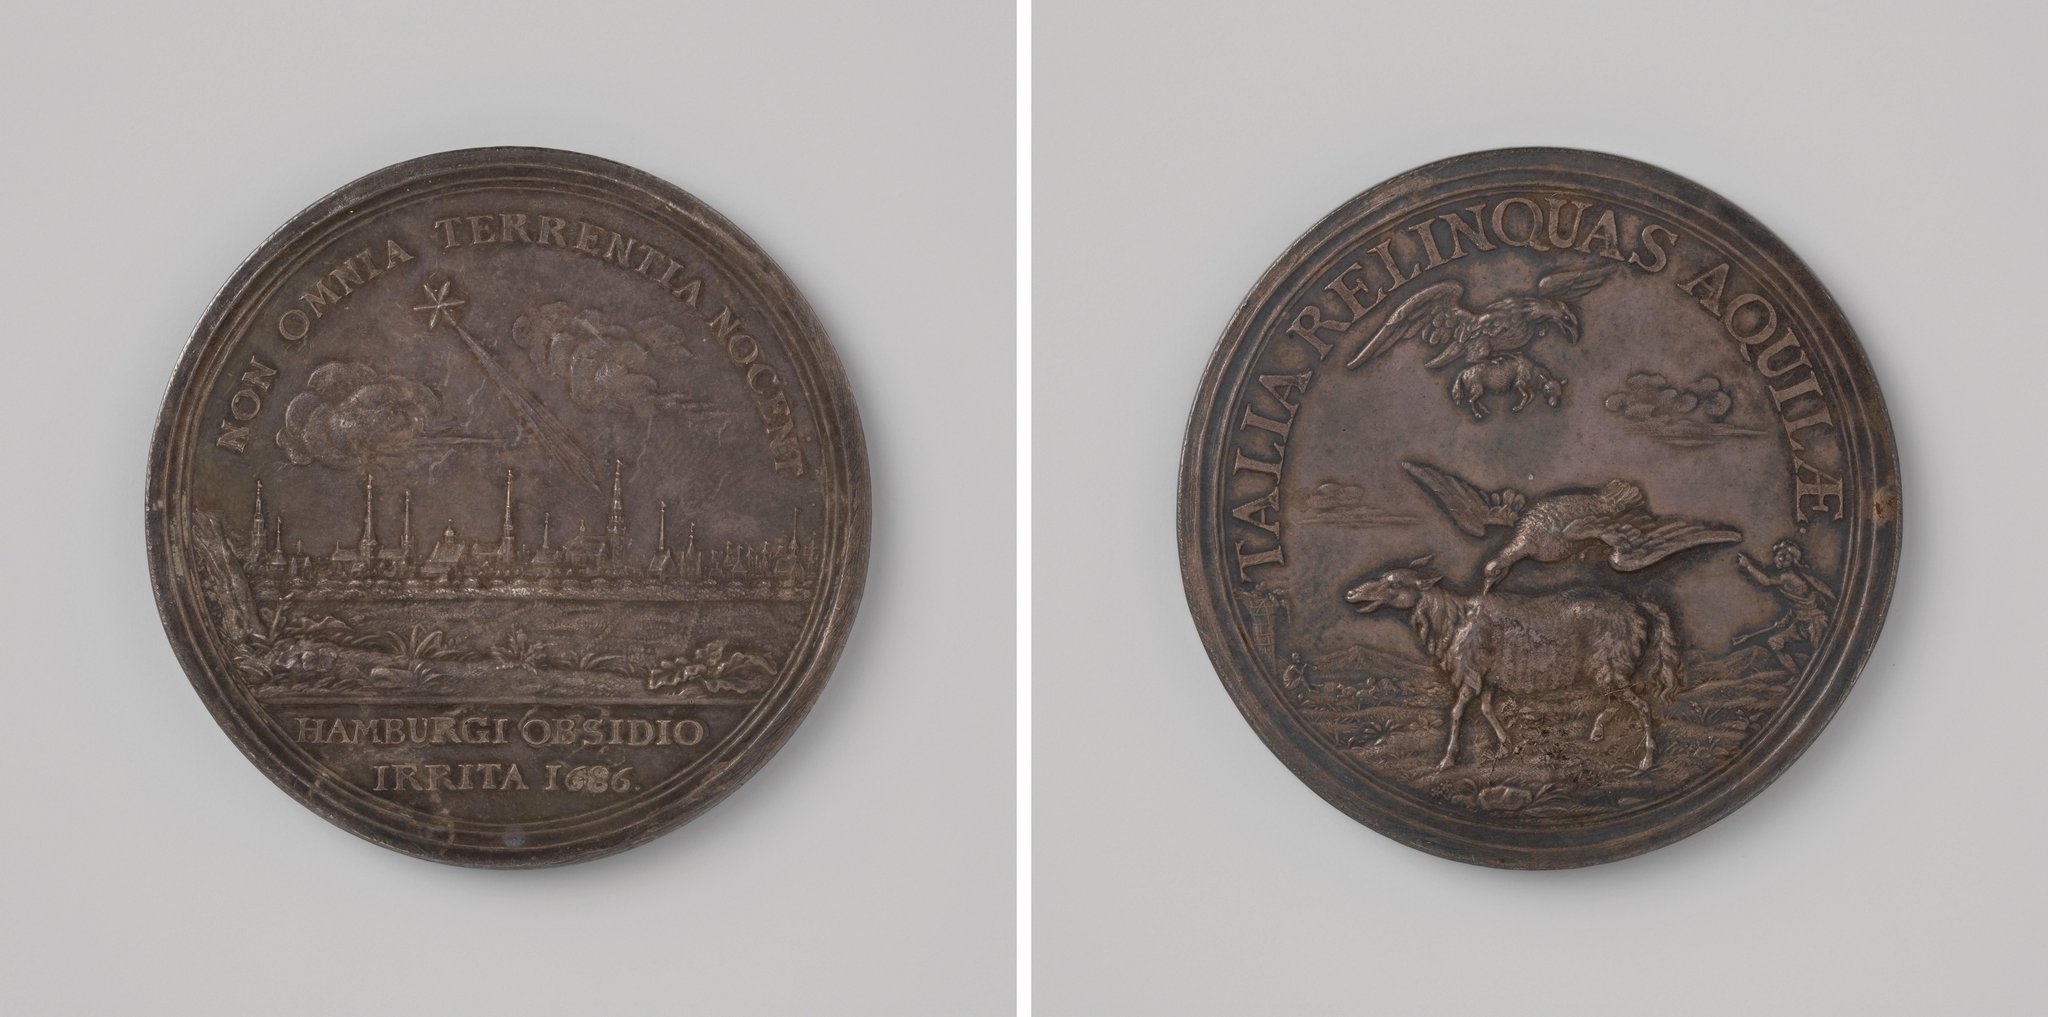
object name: history medal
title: Mislukte belegering van Hamburg door de koning van Denemarken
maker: Anonymous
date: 1686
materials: silver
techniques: striking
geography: germany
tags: copenhagen (city)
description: Zilveren penning. Voorzijde: gezicht op stad Hamburg met daarboven komeet binnen omschrift. Keerzijde: arend met lam en havik met schaap binnen omschrift